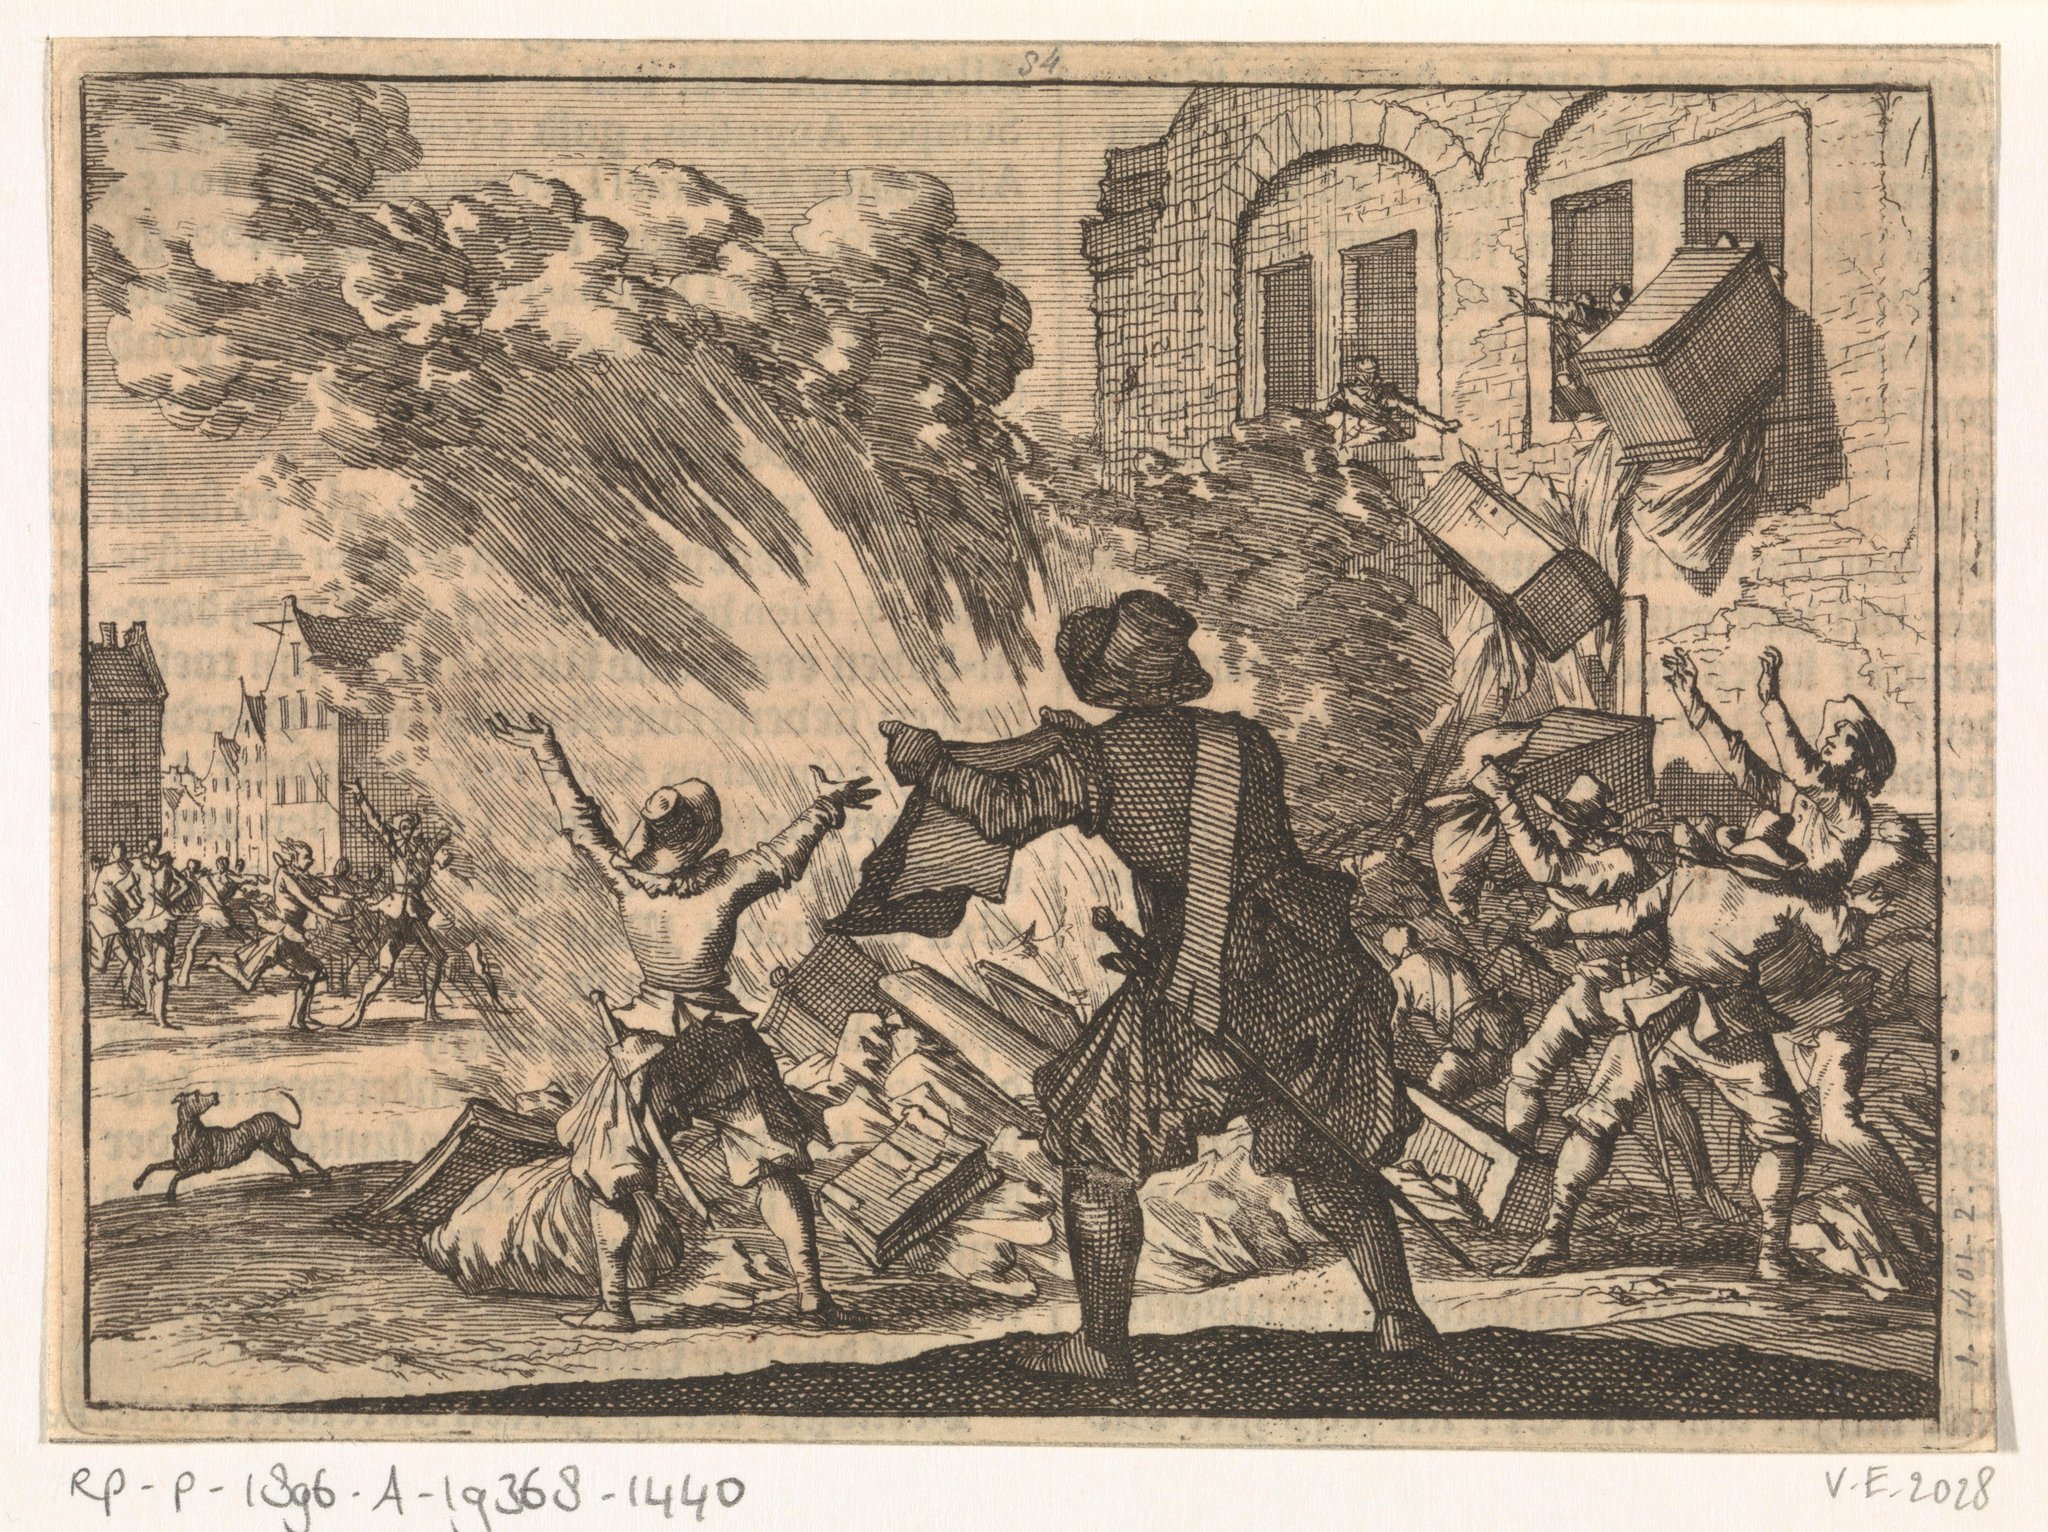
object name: print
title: Tolhuis te Lyon wordt geplunderd naar aanleiding van verhoogde accijnzen, 1625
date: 1698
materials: paper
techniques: etching, letterpress printing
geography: leiden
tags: plundering ~ riot, lyon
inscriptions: collector's mark: Lugt 2228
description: Illustratie uit: Gottfried, Johann Ludwig. Historische kronyck; vervattende een (...) beschrijvingh der aldergedenckwaerdigste geschiedenissen des weerelds, van den aenvangh der scheppingh tot (...) 1576 (2 delen). Leiden: Pieter van der Aa, 1698, dl. I, p. 1401.